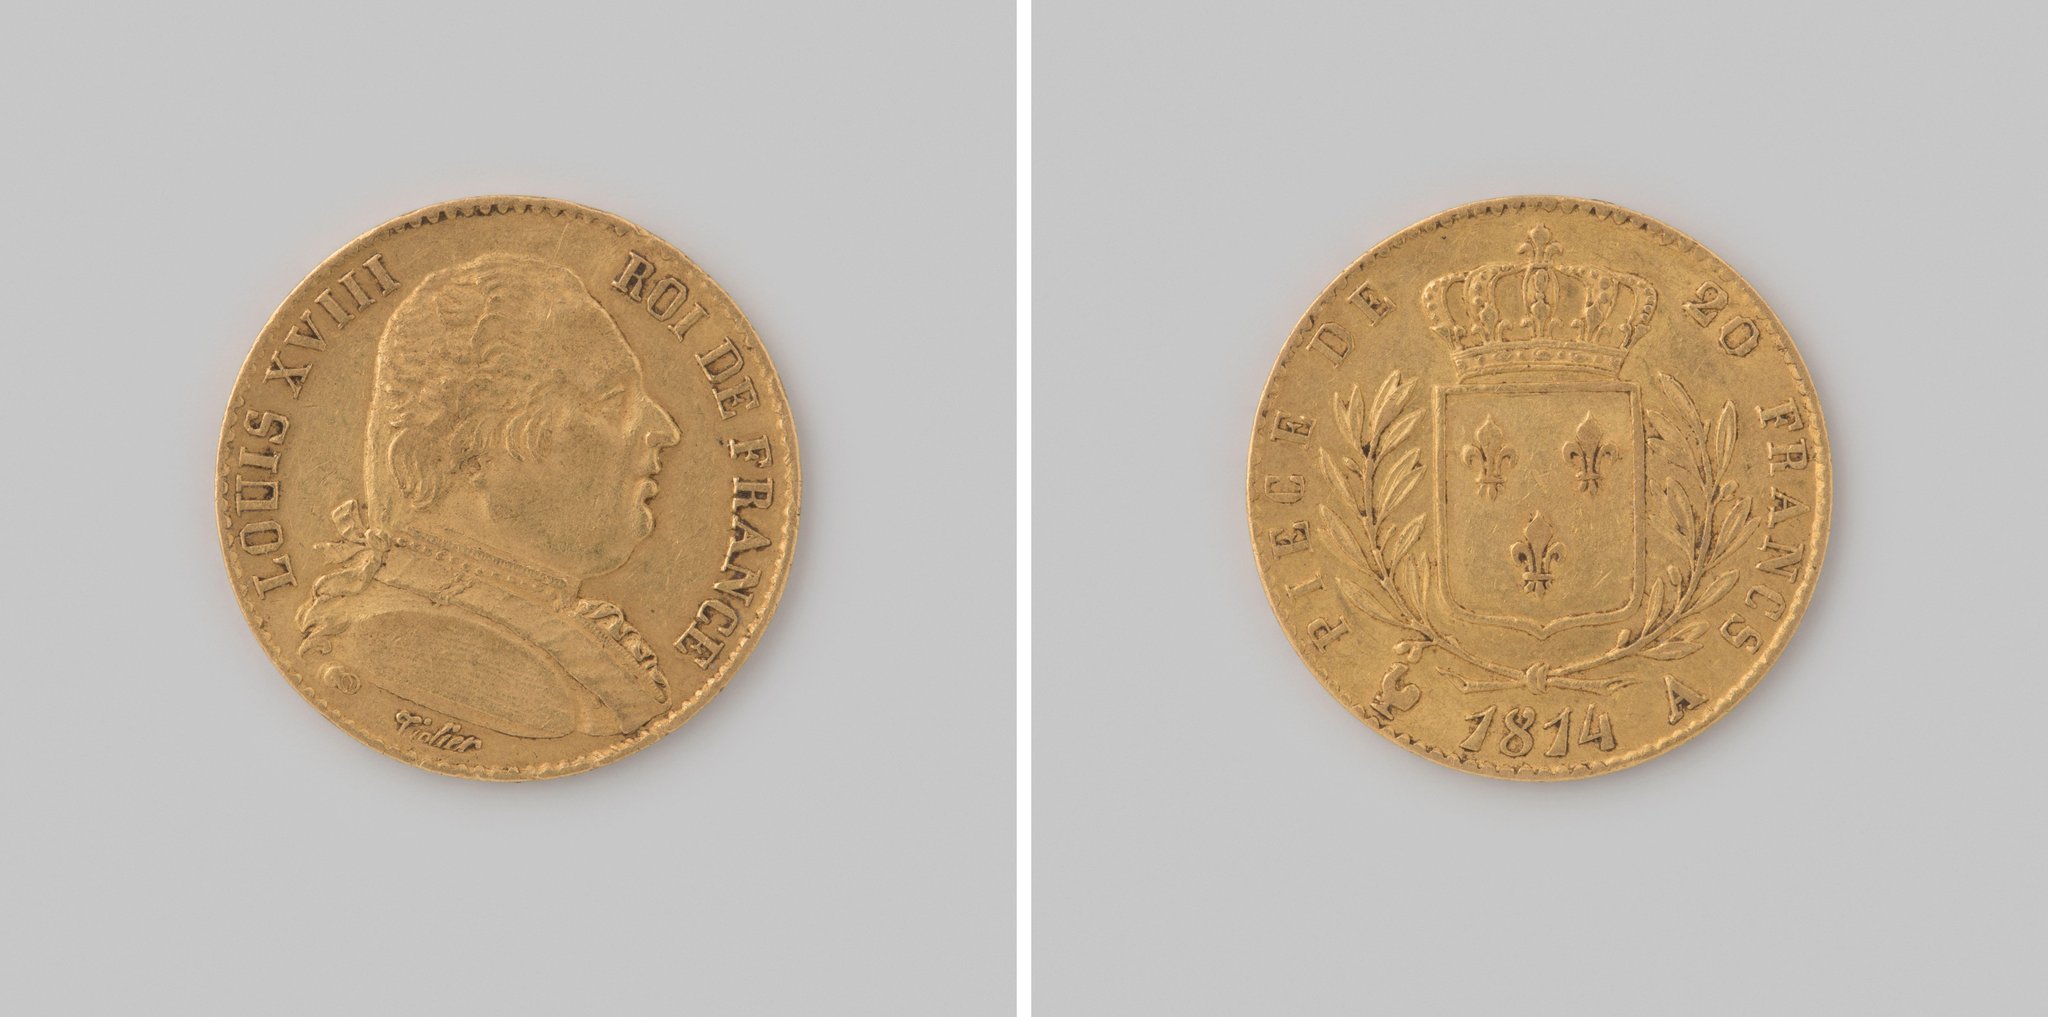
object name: twintig franc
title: Twintig francs uit het koninkrijk Frankrijk van Lodewijk XVIII, 1814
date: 1814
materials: gold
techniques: striking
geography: paris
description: Gouden munt. Voorzijde: borstbeeld van de koning naar rechts. Keerzijde: binnen twee samengebonden lauriertakken gekroond wapenschild. Waarde-aanduiding in omschrift. Onderaan jaartal. Rechts daarvan letter A [=Parijs]. Randschrift.